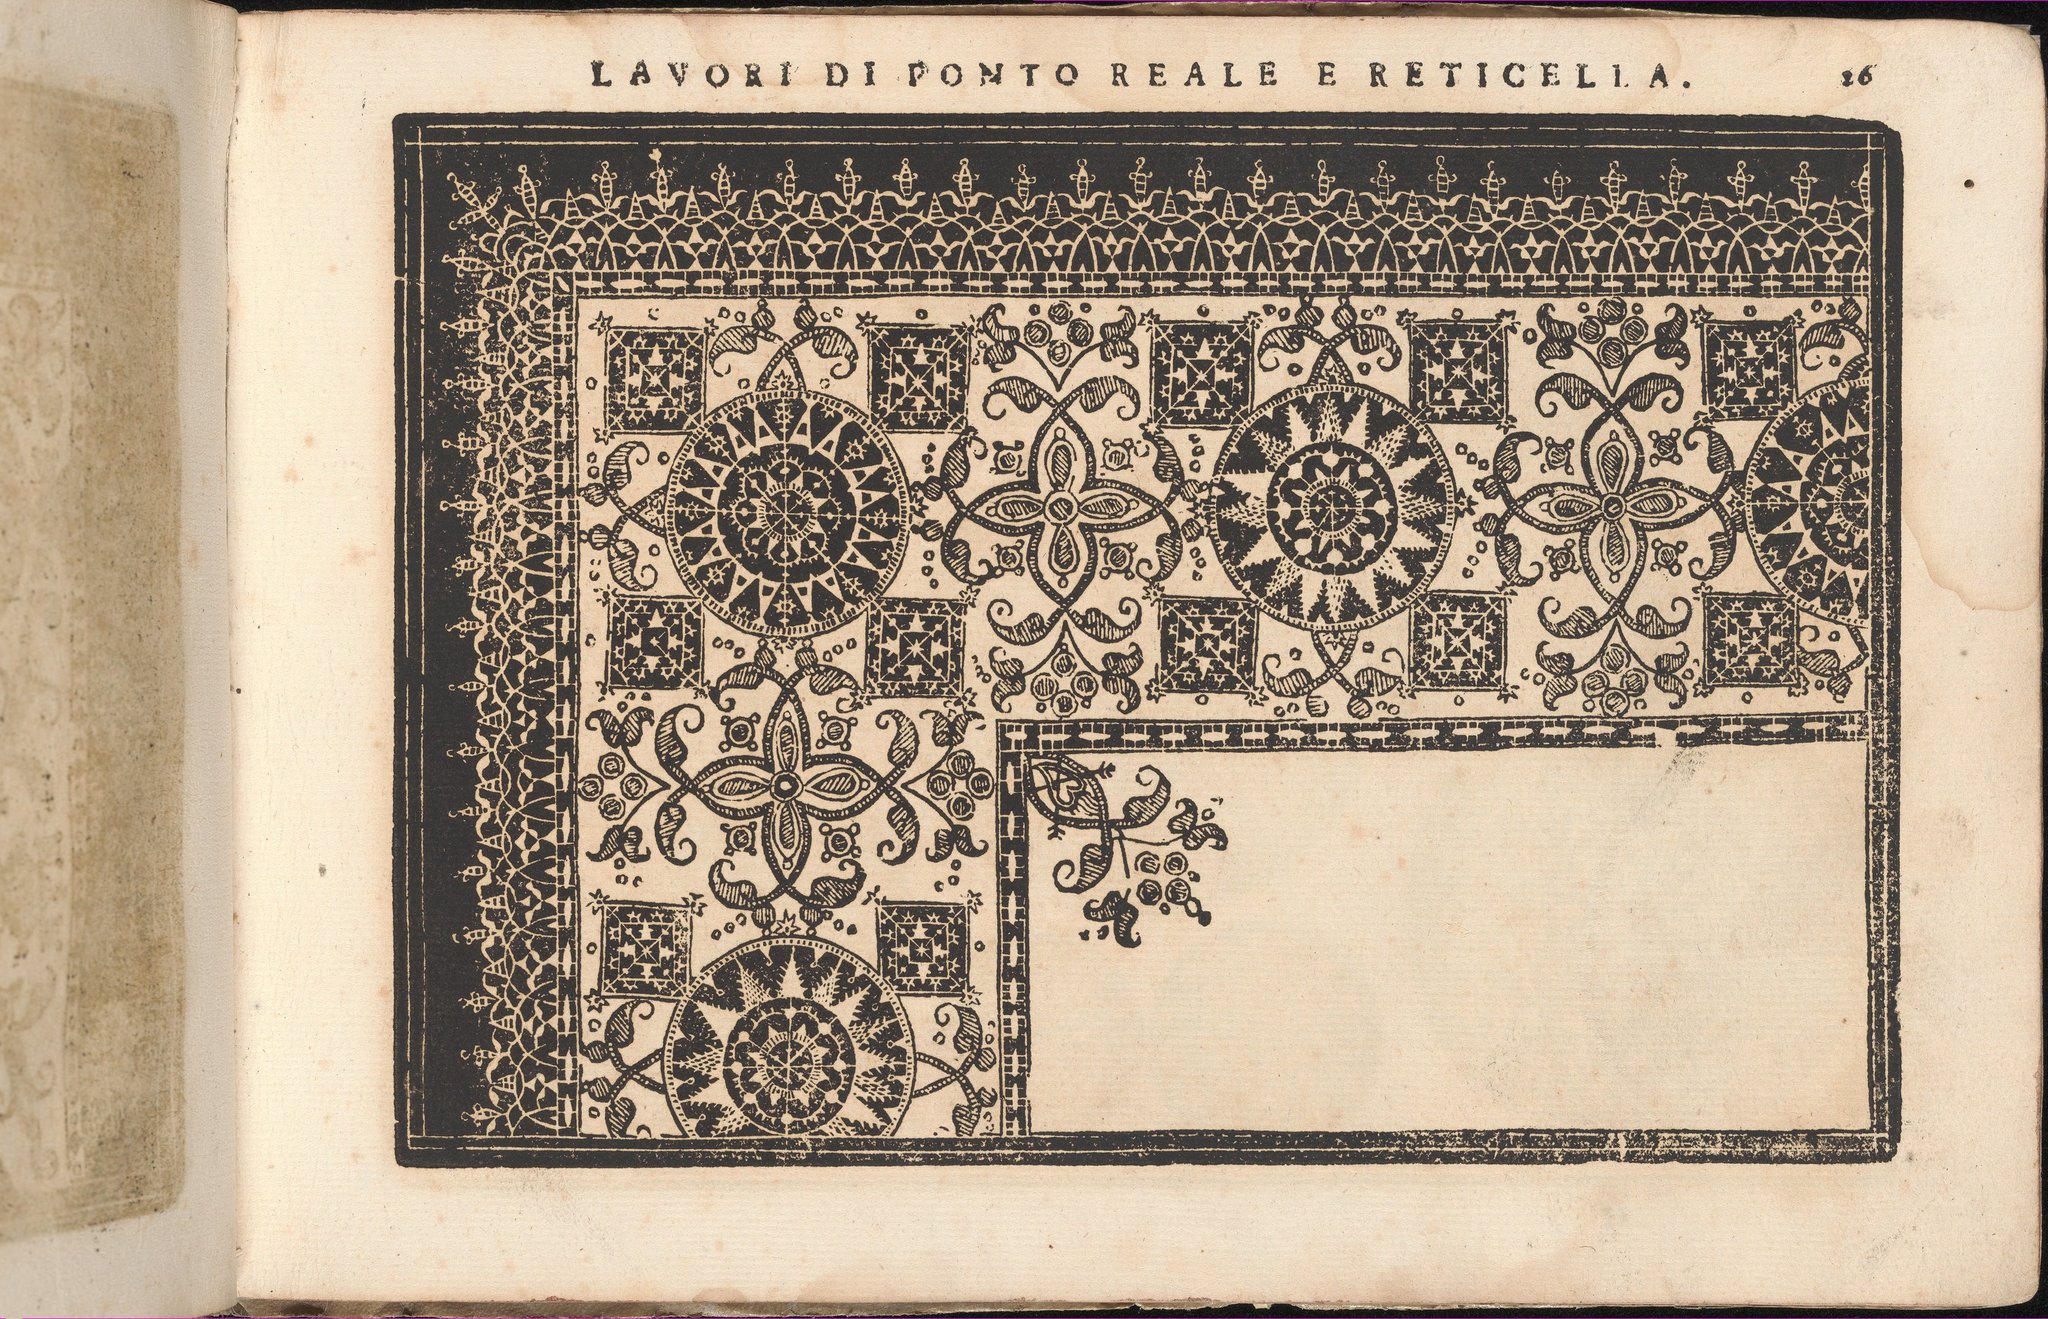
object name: book print ornament architecture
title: Teatro delle Nobili et Virtuose Donne..., page 26 (recto)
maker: isabella catanea parasole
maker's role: author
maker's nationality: italian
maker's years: 1565-1625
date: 1616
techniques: engraving, woodcut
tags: ornament